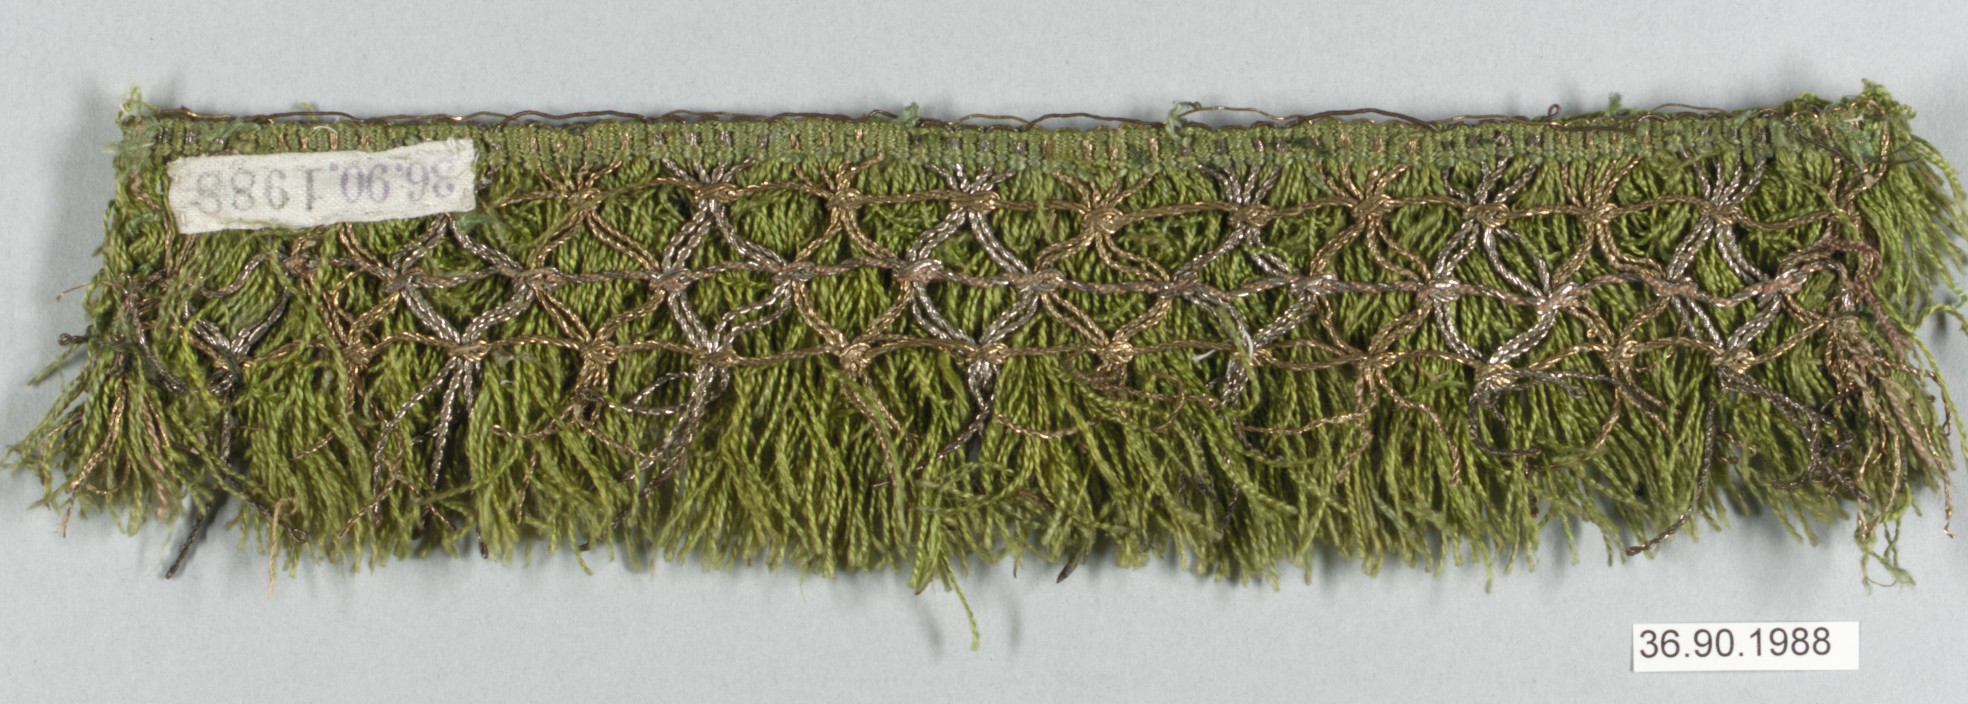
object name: fringe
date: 1601-1633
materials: metal thread, silk